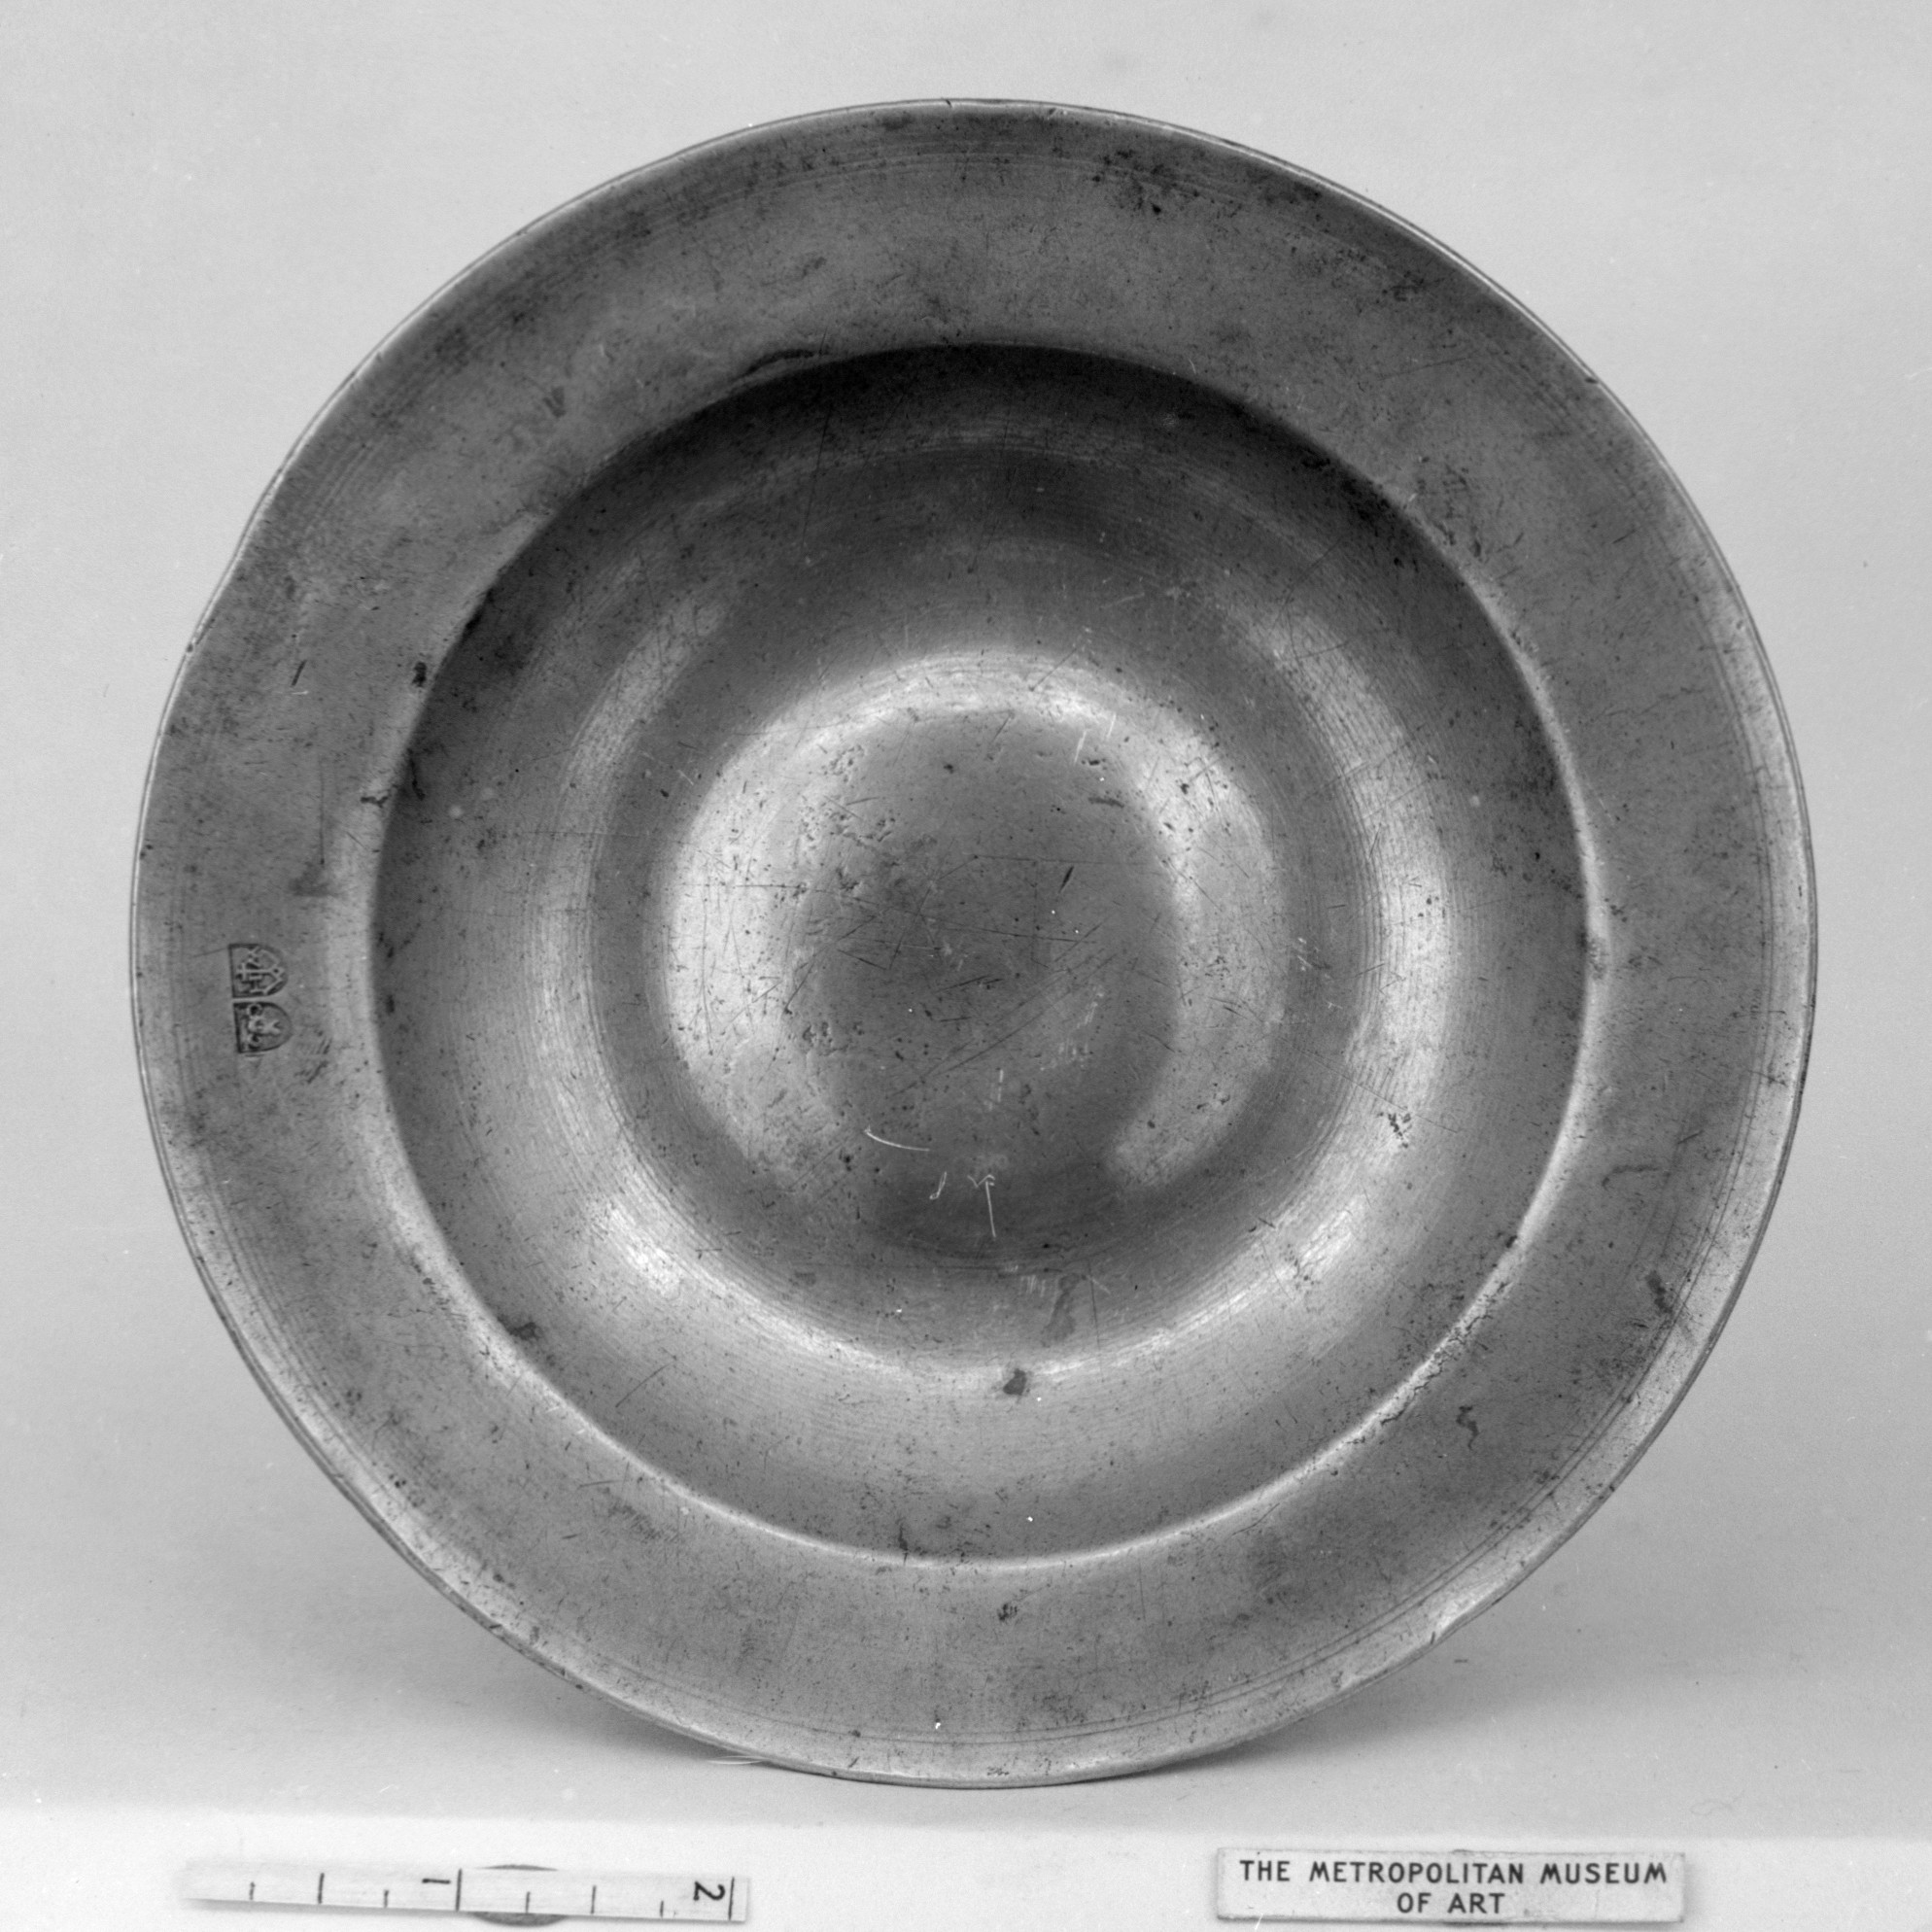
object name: plate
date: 1601-1700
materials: pewter